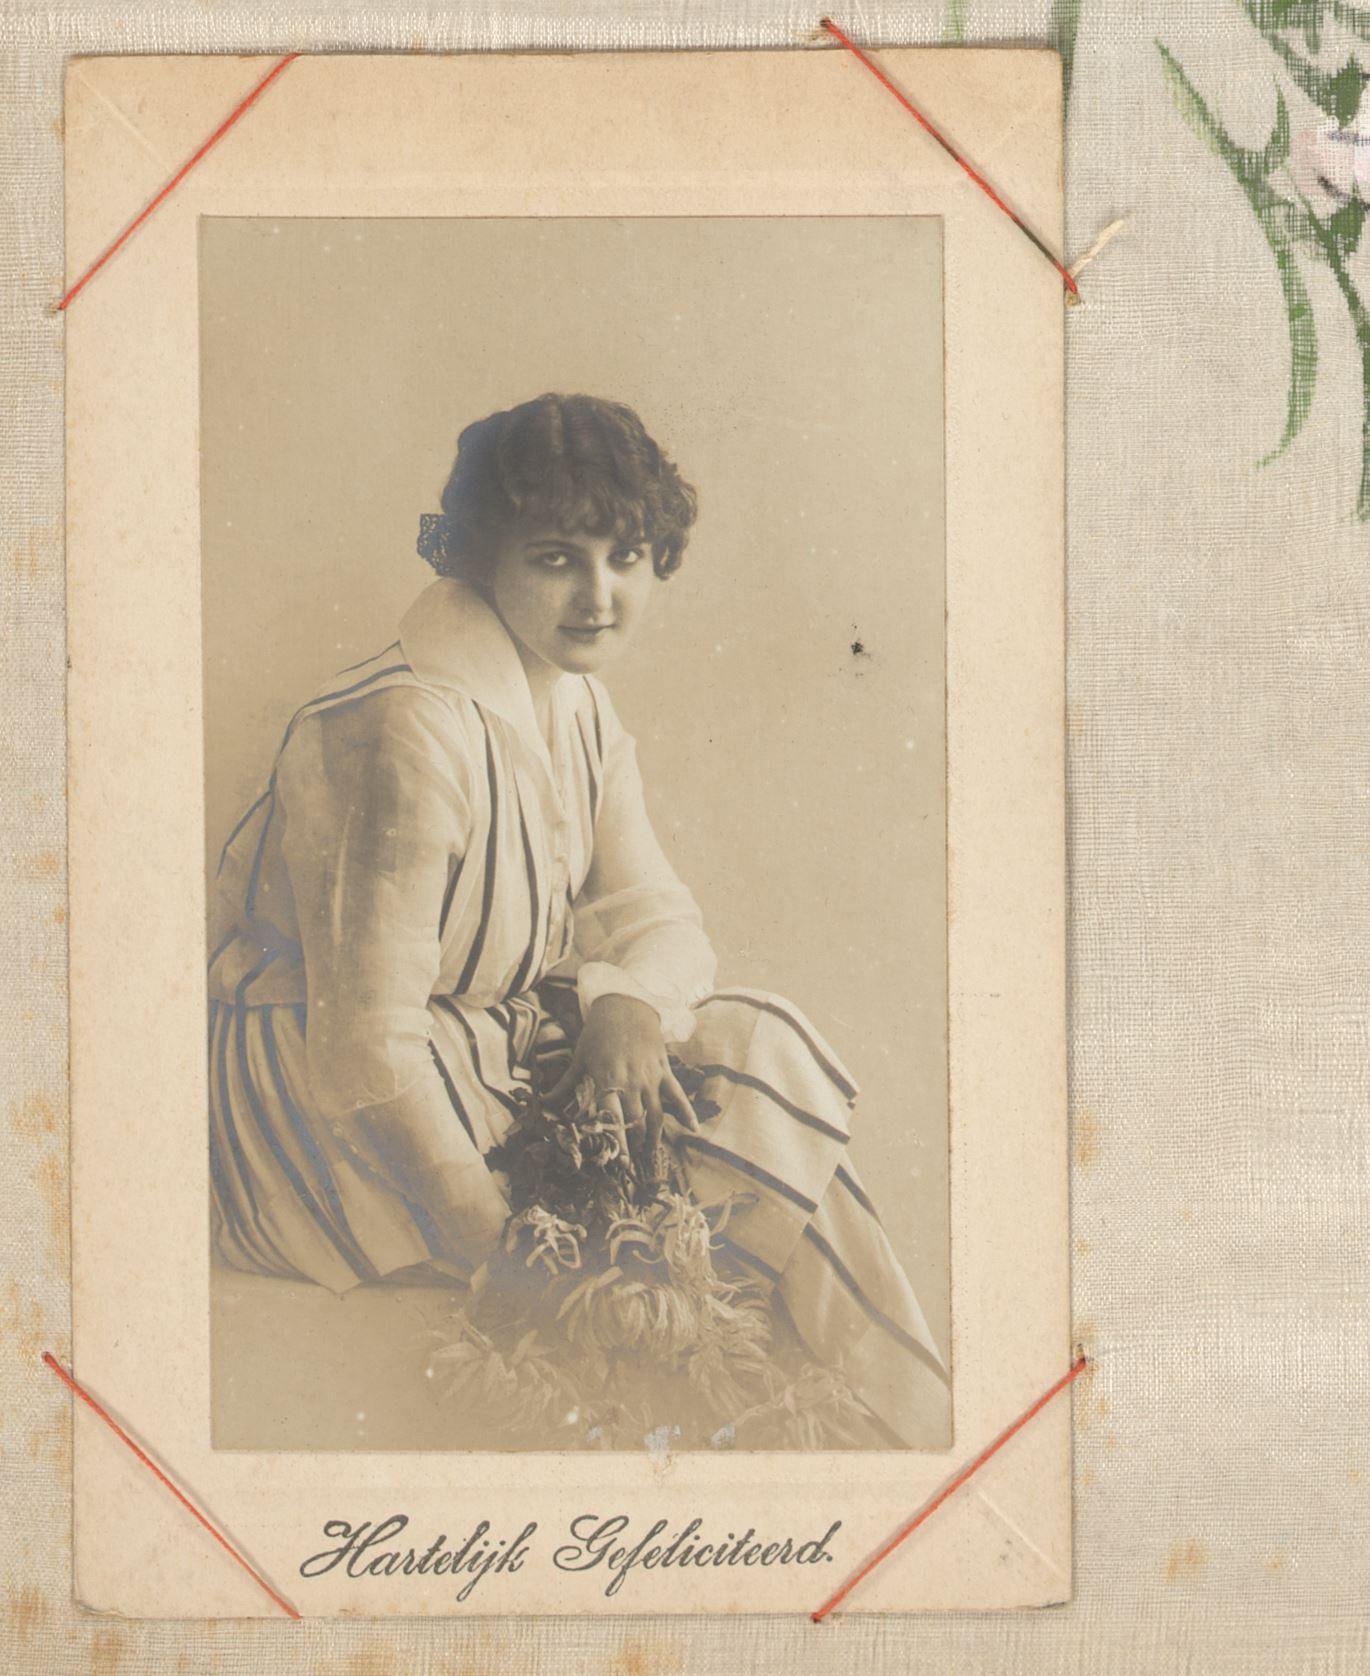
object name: album leaf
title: Portret van een vrouw met bloemen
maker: Anonymous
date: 1880-1920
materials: paint, photographic support, silk, textile, watercolor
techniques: brush, gelatin silver print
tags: flowers, adult woman, historical persons